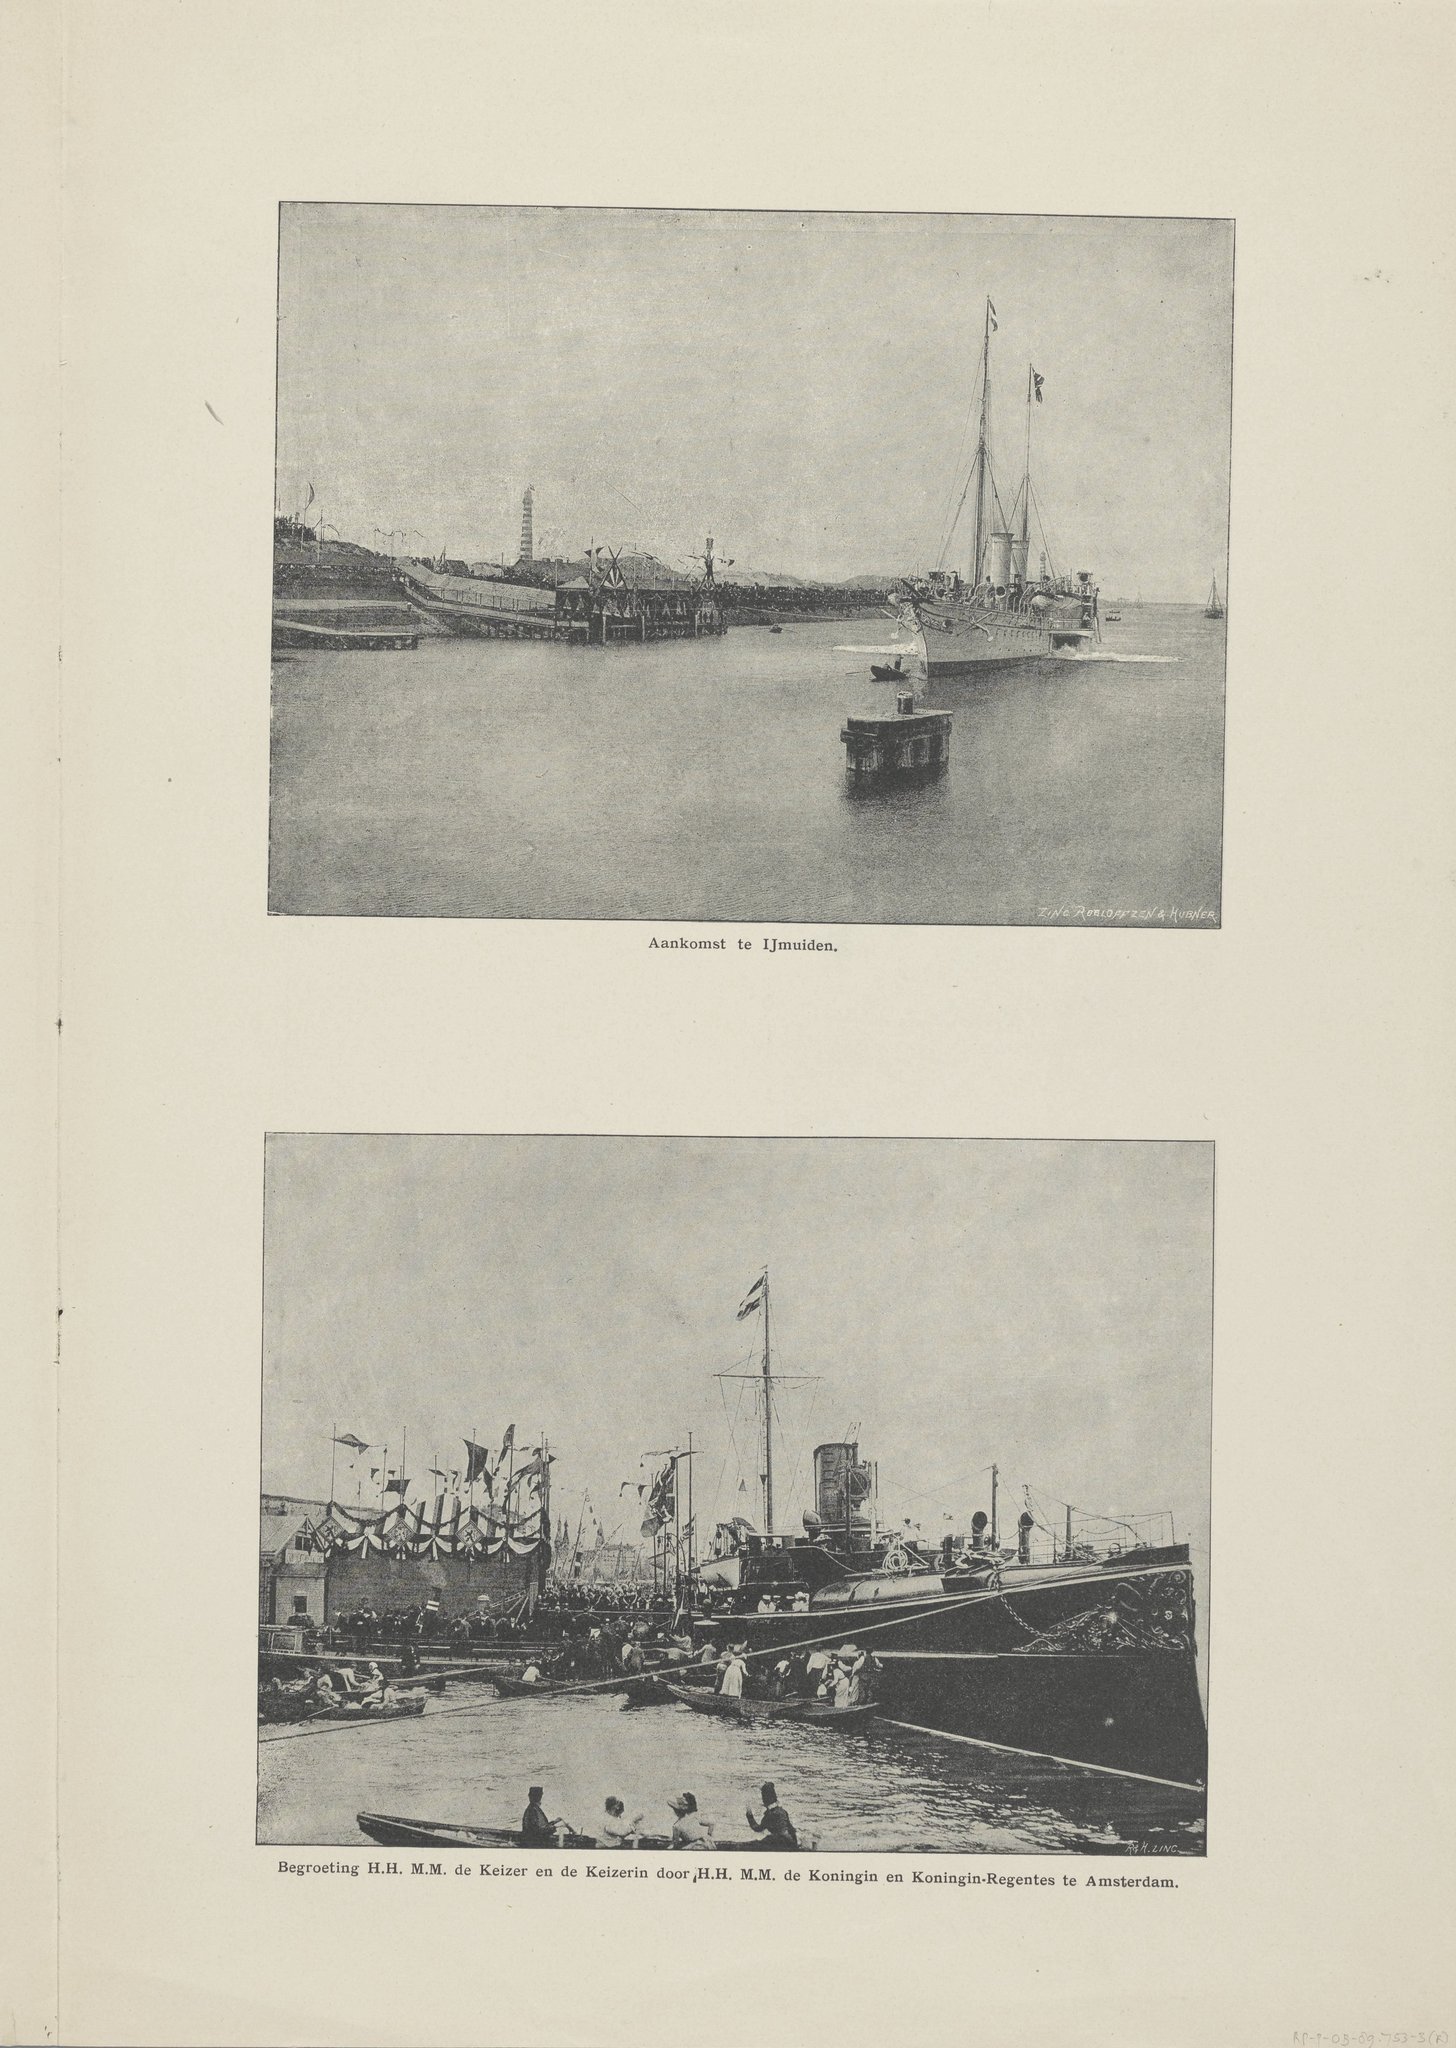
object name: print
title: Aankomst te IJmuiden / Begroeting H.H.M.M. de Keizer en de Keizerin door H.H.M.M. de Koningin en Koningin-Regentes te Amsterdam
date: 1807-1891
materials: paper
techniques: lithography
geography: north holland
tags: the hague, print maker, wilhelmina of the netherlands, emma (queen consort of the netherlands), wilhelm ii (keizer van duitsland), augusta victoria (keizerin van duitsland), amsterdam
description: Twee platen: aankomst van het jacht de 'Hohenzollern' van de Duitse keizer en keizerin bij IJmuiden en vervolgens van het adviesjacht 'Jagd' te Amsterdam. Illustratie in het blad bestaande uit vier bladen met tekst en illustraties, uitgegeven ter gelegenheid van het bezoek van de keizer Wilhelm II van Duitsland en de keizerin aan Amsterdam van 1-3 juli 1891.